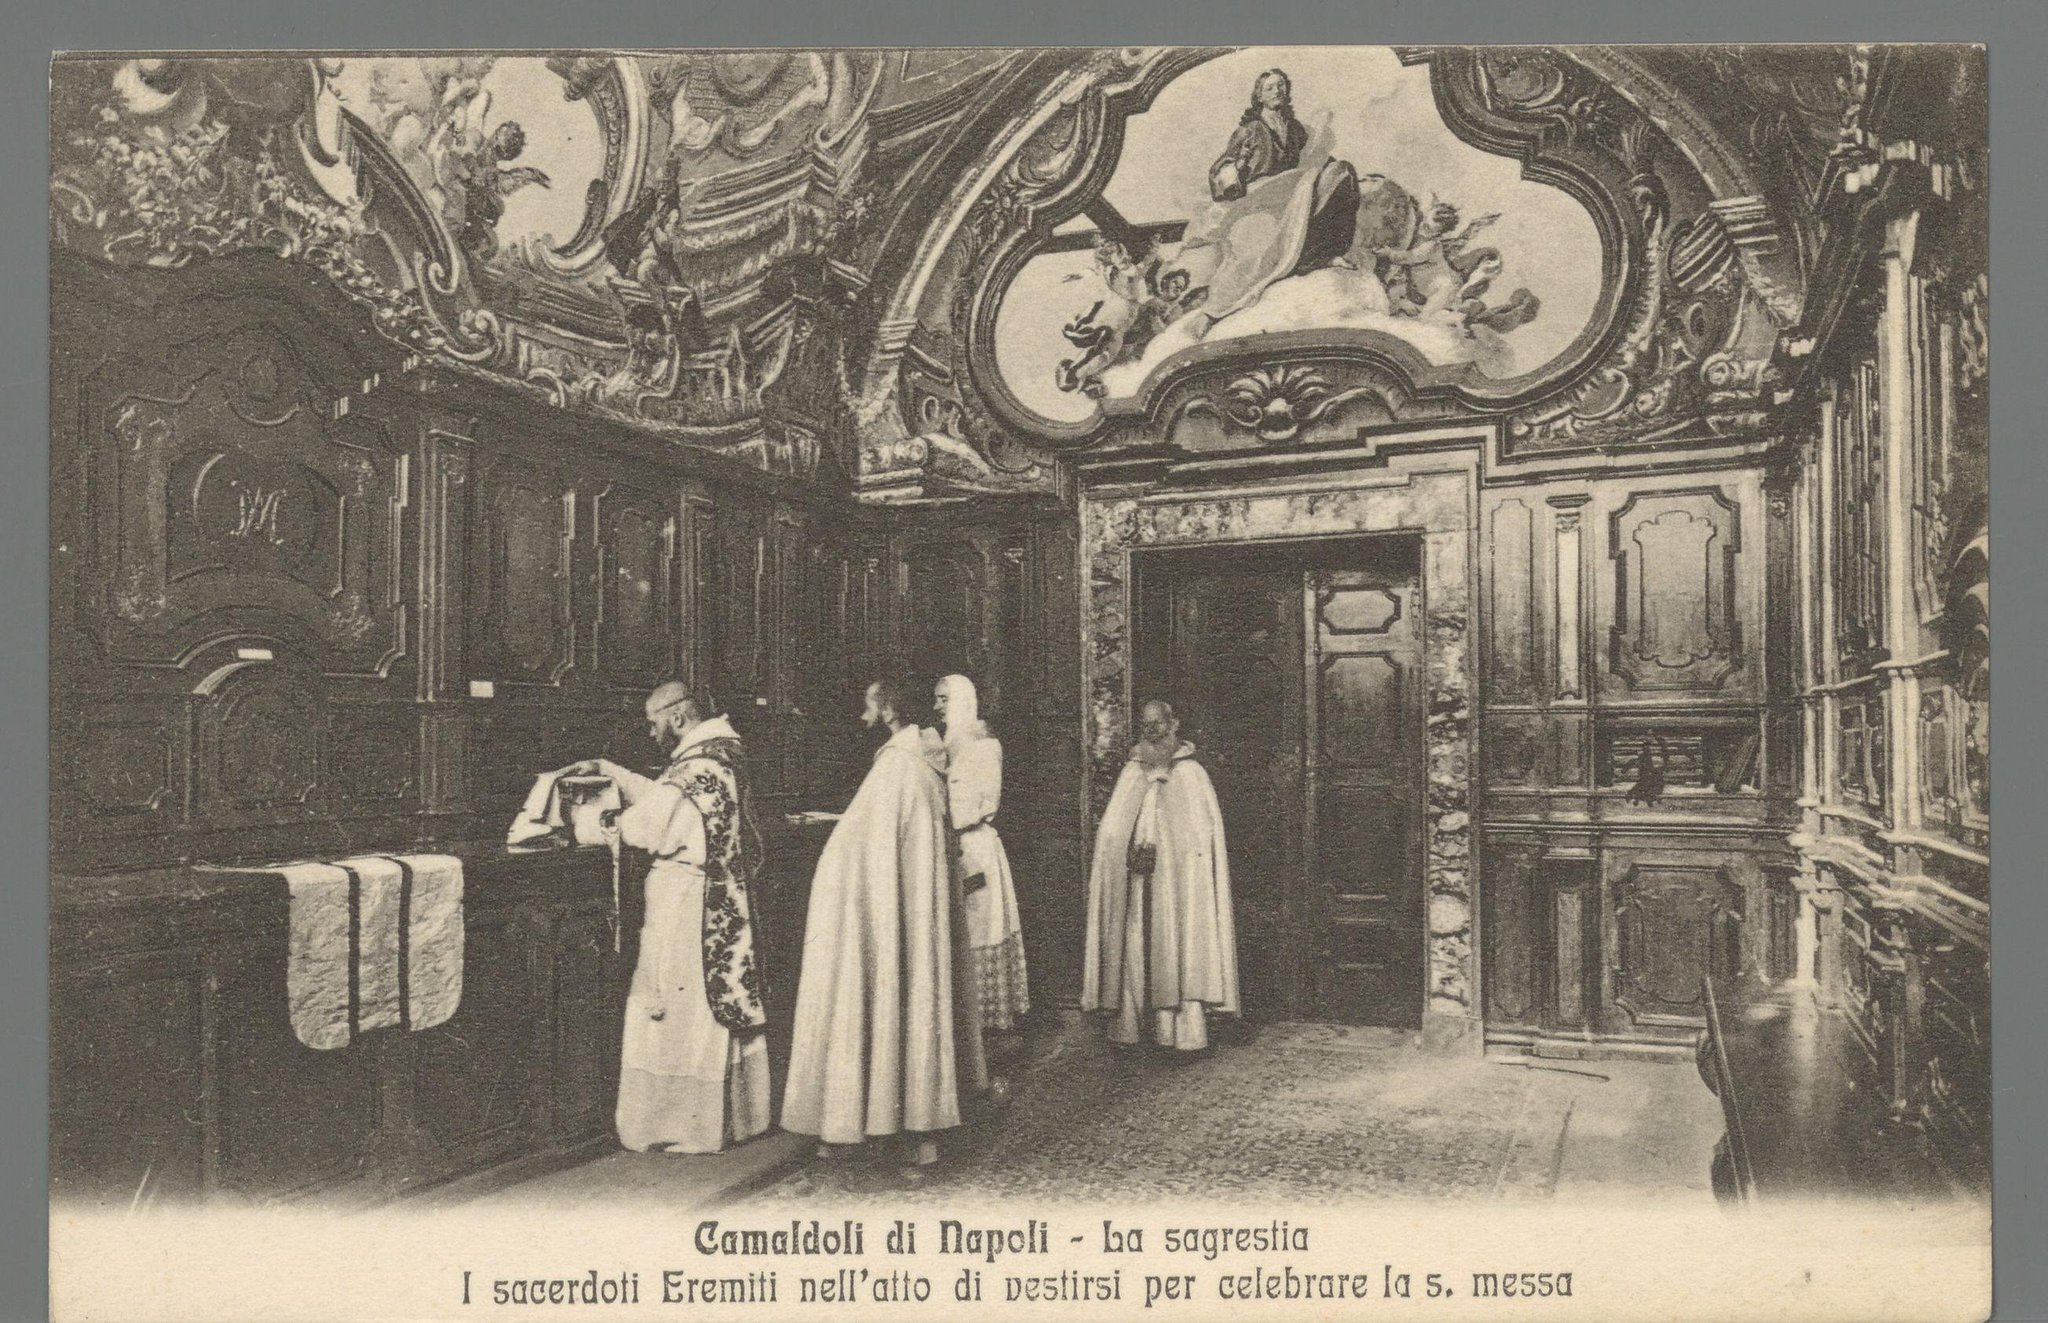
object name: photomechanical print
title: Camaldoli di Napoli. La sagrestia. I sacerdoti Eremiti nell'atto di vestirsi per celebrare la s. messa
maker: Anonymous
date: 1906-1910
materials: cardboard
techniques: photograph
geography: terni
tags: parts of church interior: sacristy, monk(s), friar(s), camaldoli